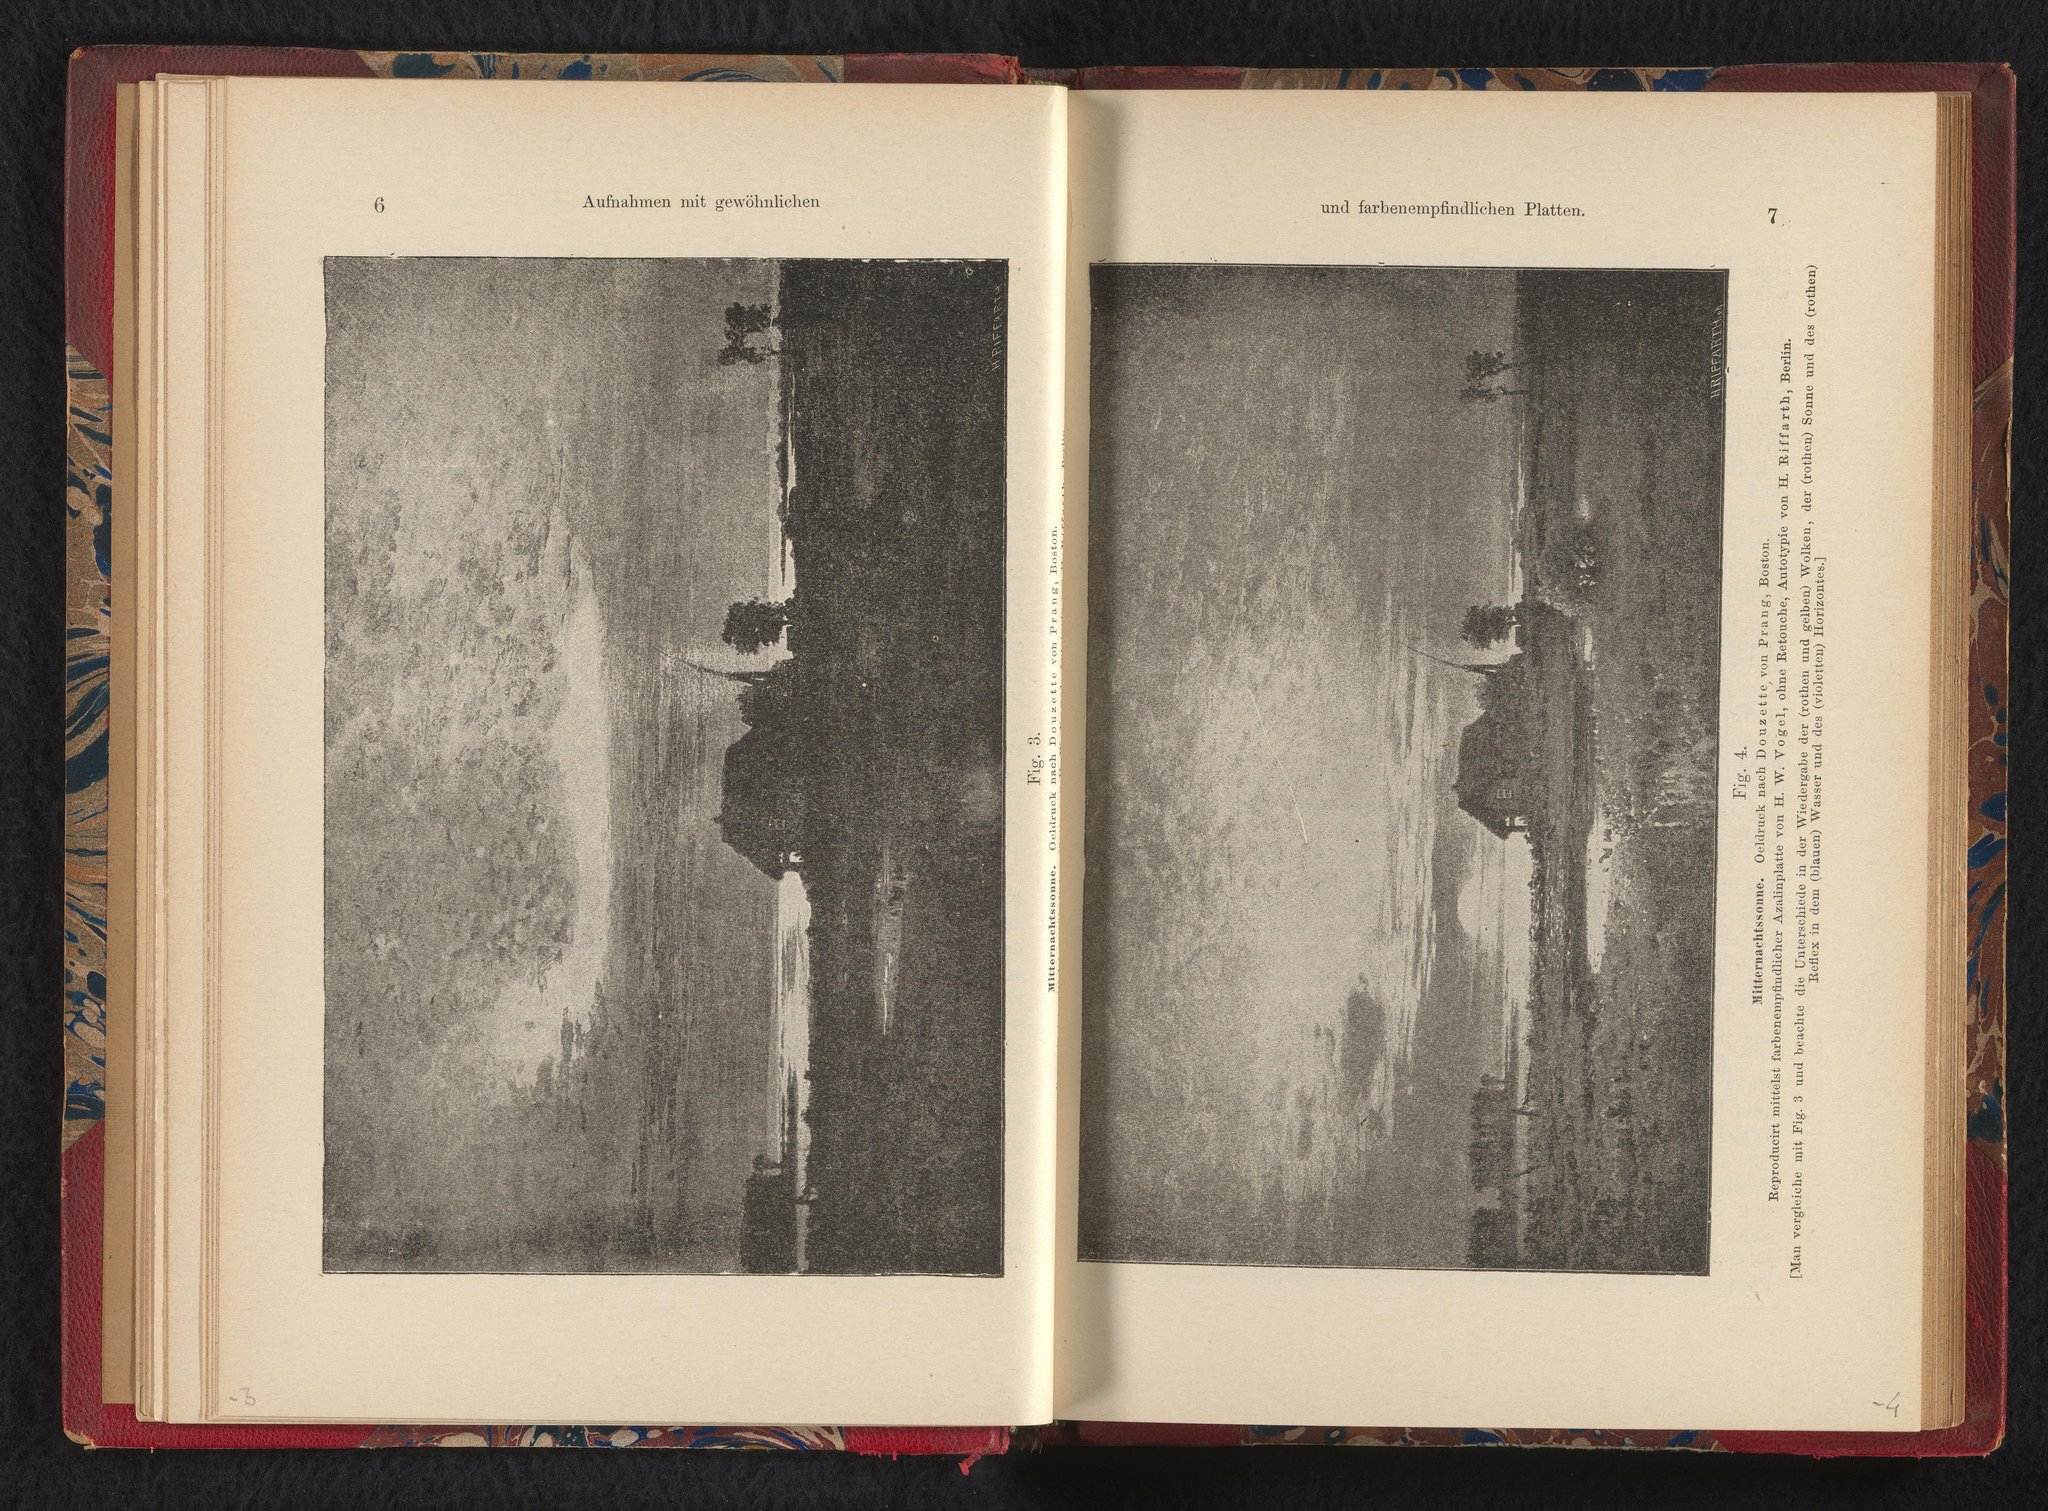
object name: photomechanical print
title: Reproductie van het schilderij 'Mitternachtsonne' van Louis Douzette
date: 1886-1891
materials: paper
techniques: autotype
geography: berlin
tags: sunset, farm or solitary house in landscape